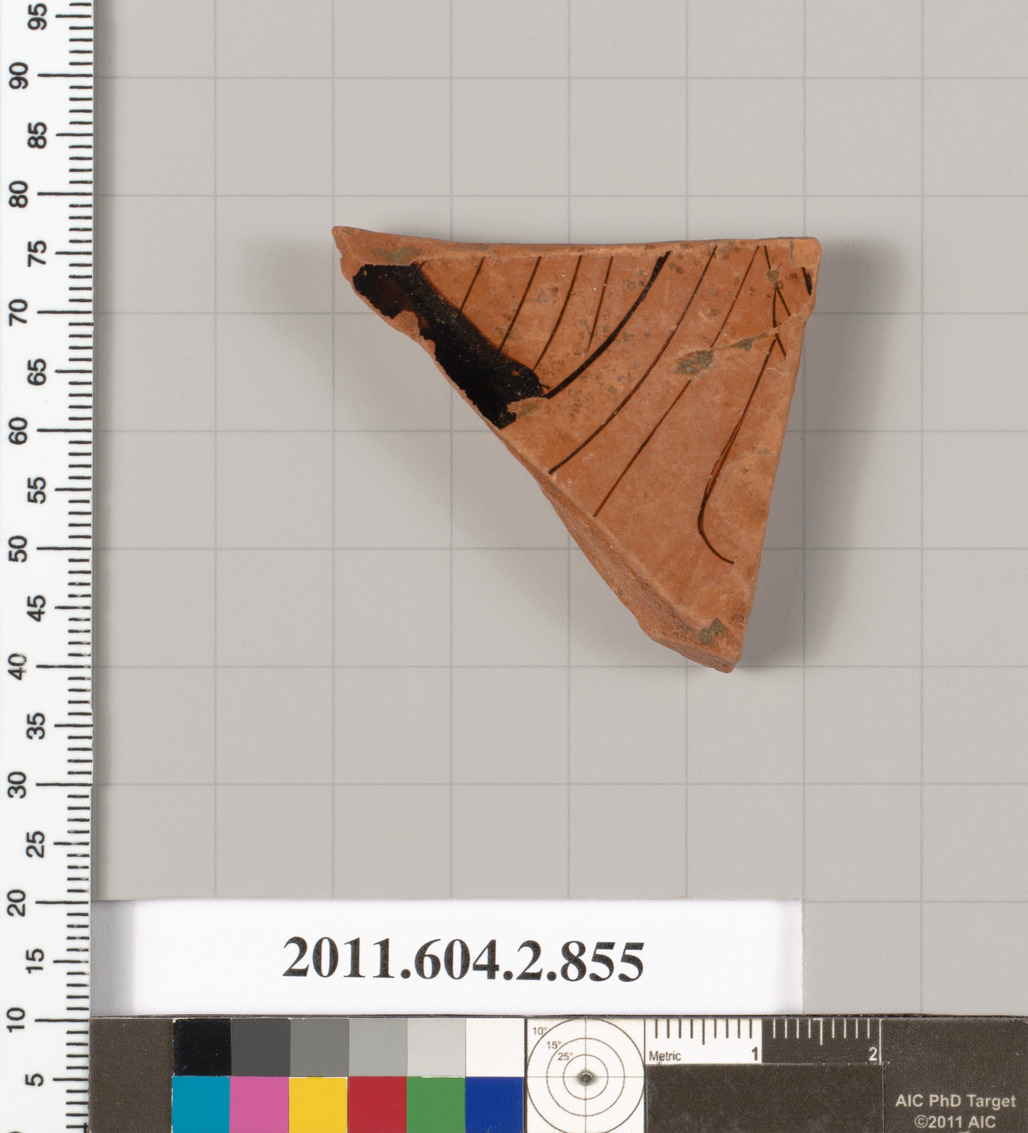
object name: bell krater fragment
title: Terracotta fragment of a bell-krater (bowl for mixing wine and water)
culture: greek, attic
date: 450-440 BCE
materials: terracotta